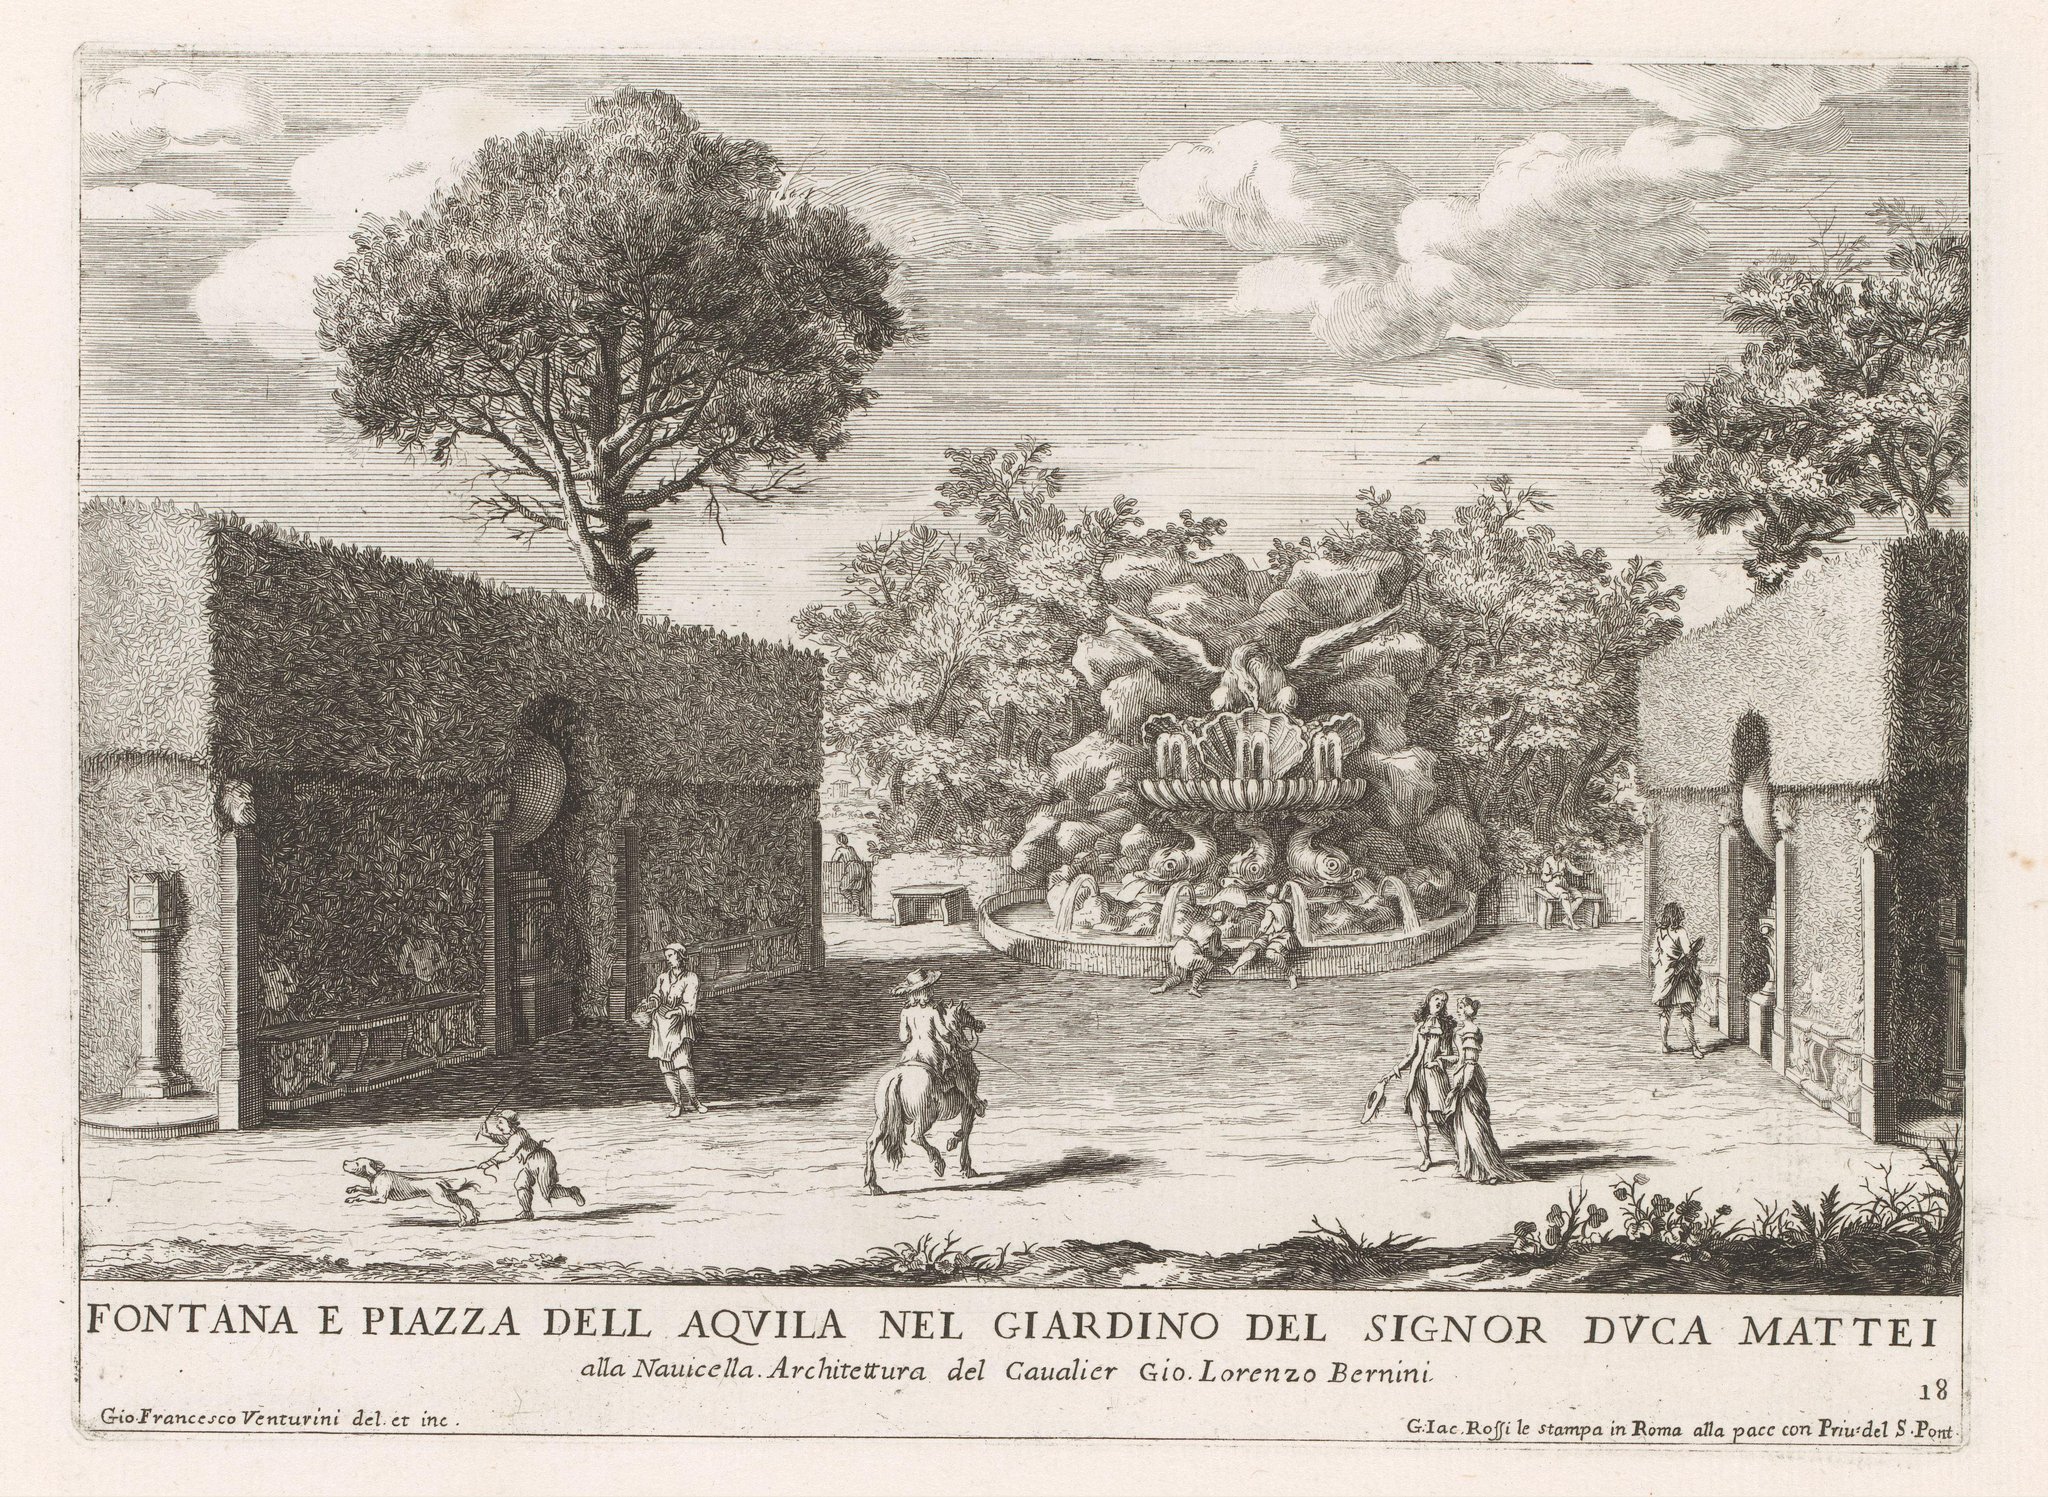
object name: print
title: Fonteinen in de paleizen en tuinen van Rome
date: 1653-1691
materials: paper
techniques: etching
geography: italy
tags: ornamental fountain, rome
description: Genummerd rechtsonder: 18. De prent maakt deel uit van een album.